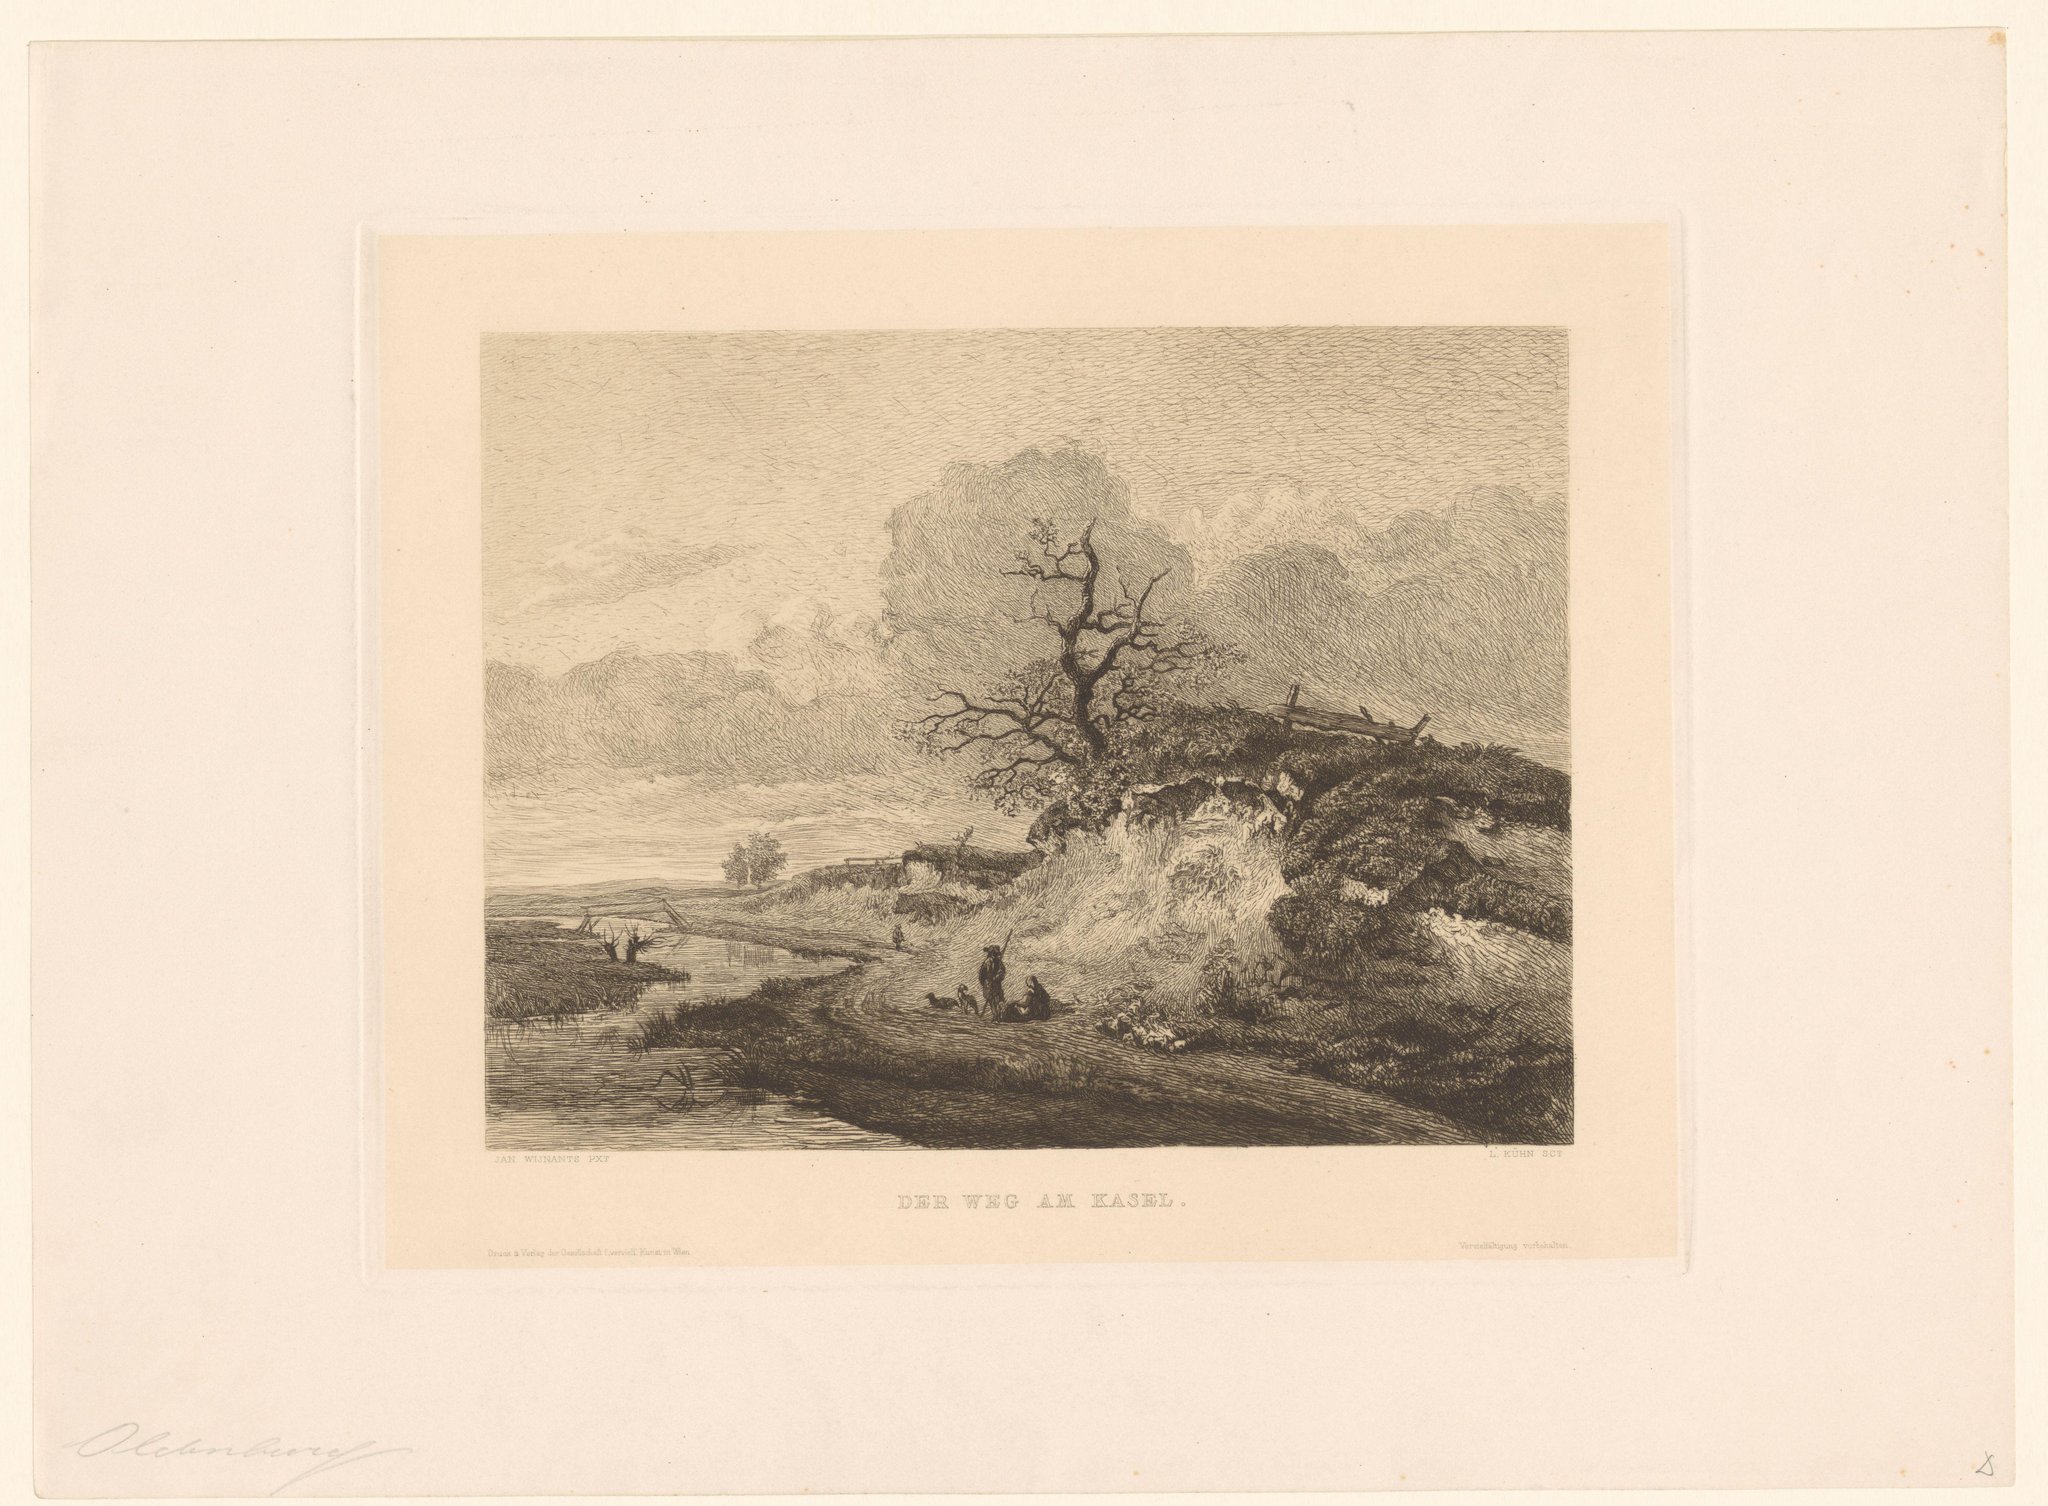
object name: print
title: Der Weg am Kasel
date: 1871-1934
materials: paper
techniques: engraving, etching, intaglio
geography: vienna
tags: herding, herdsman, herdswoman, shepherd, shepherdess, cowherd, etc., (traveller) resting in the open air, small canal, ditch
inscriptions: collector's mark: Lugt 2228